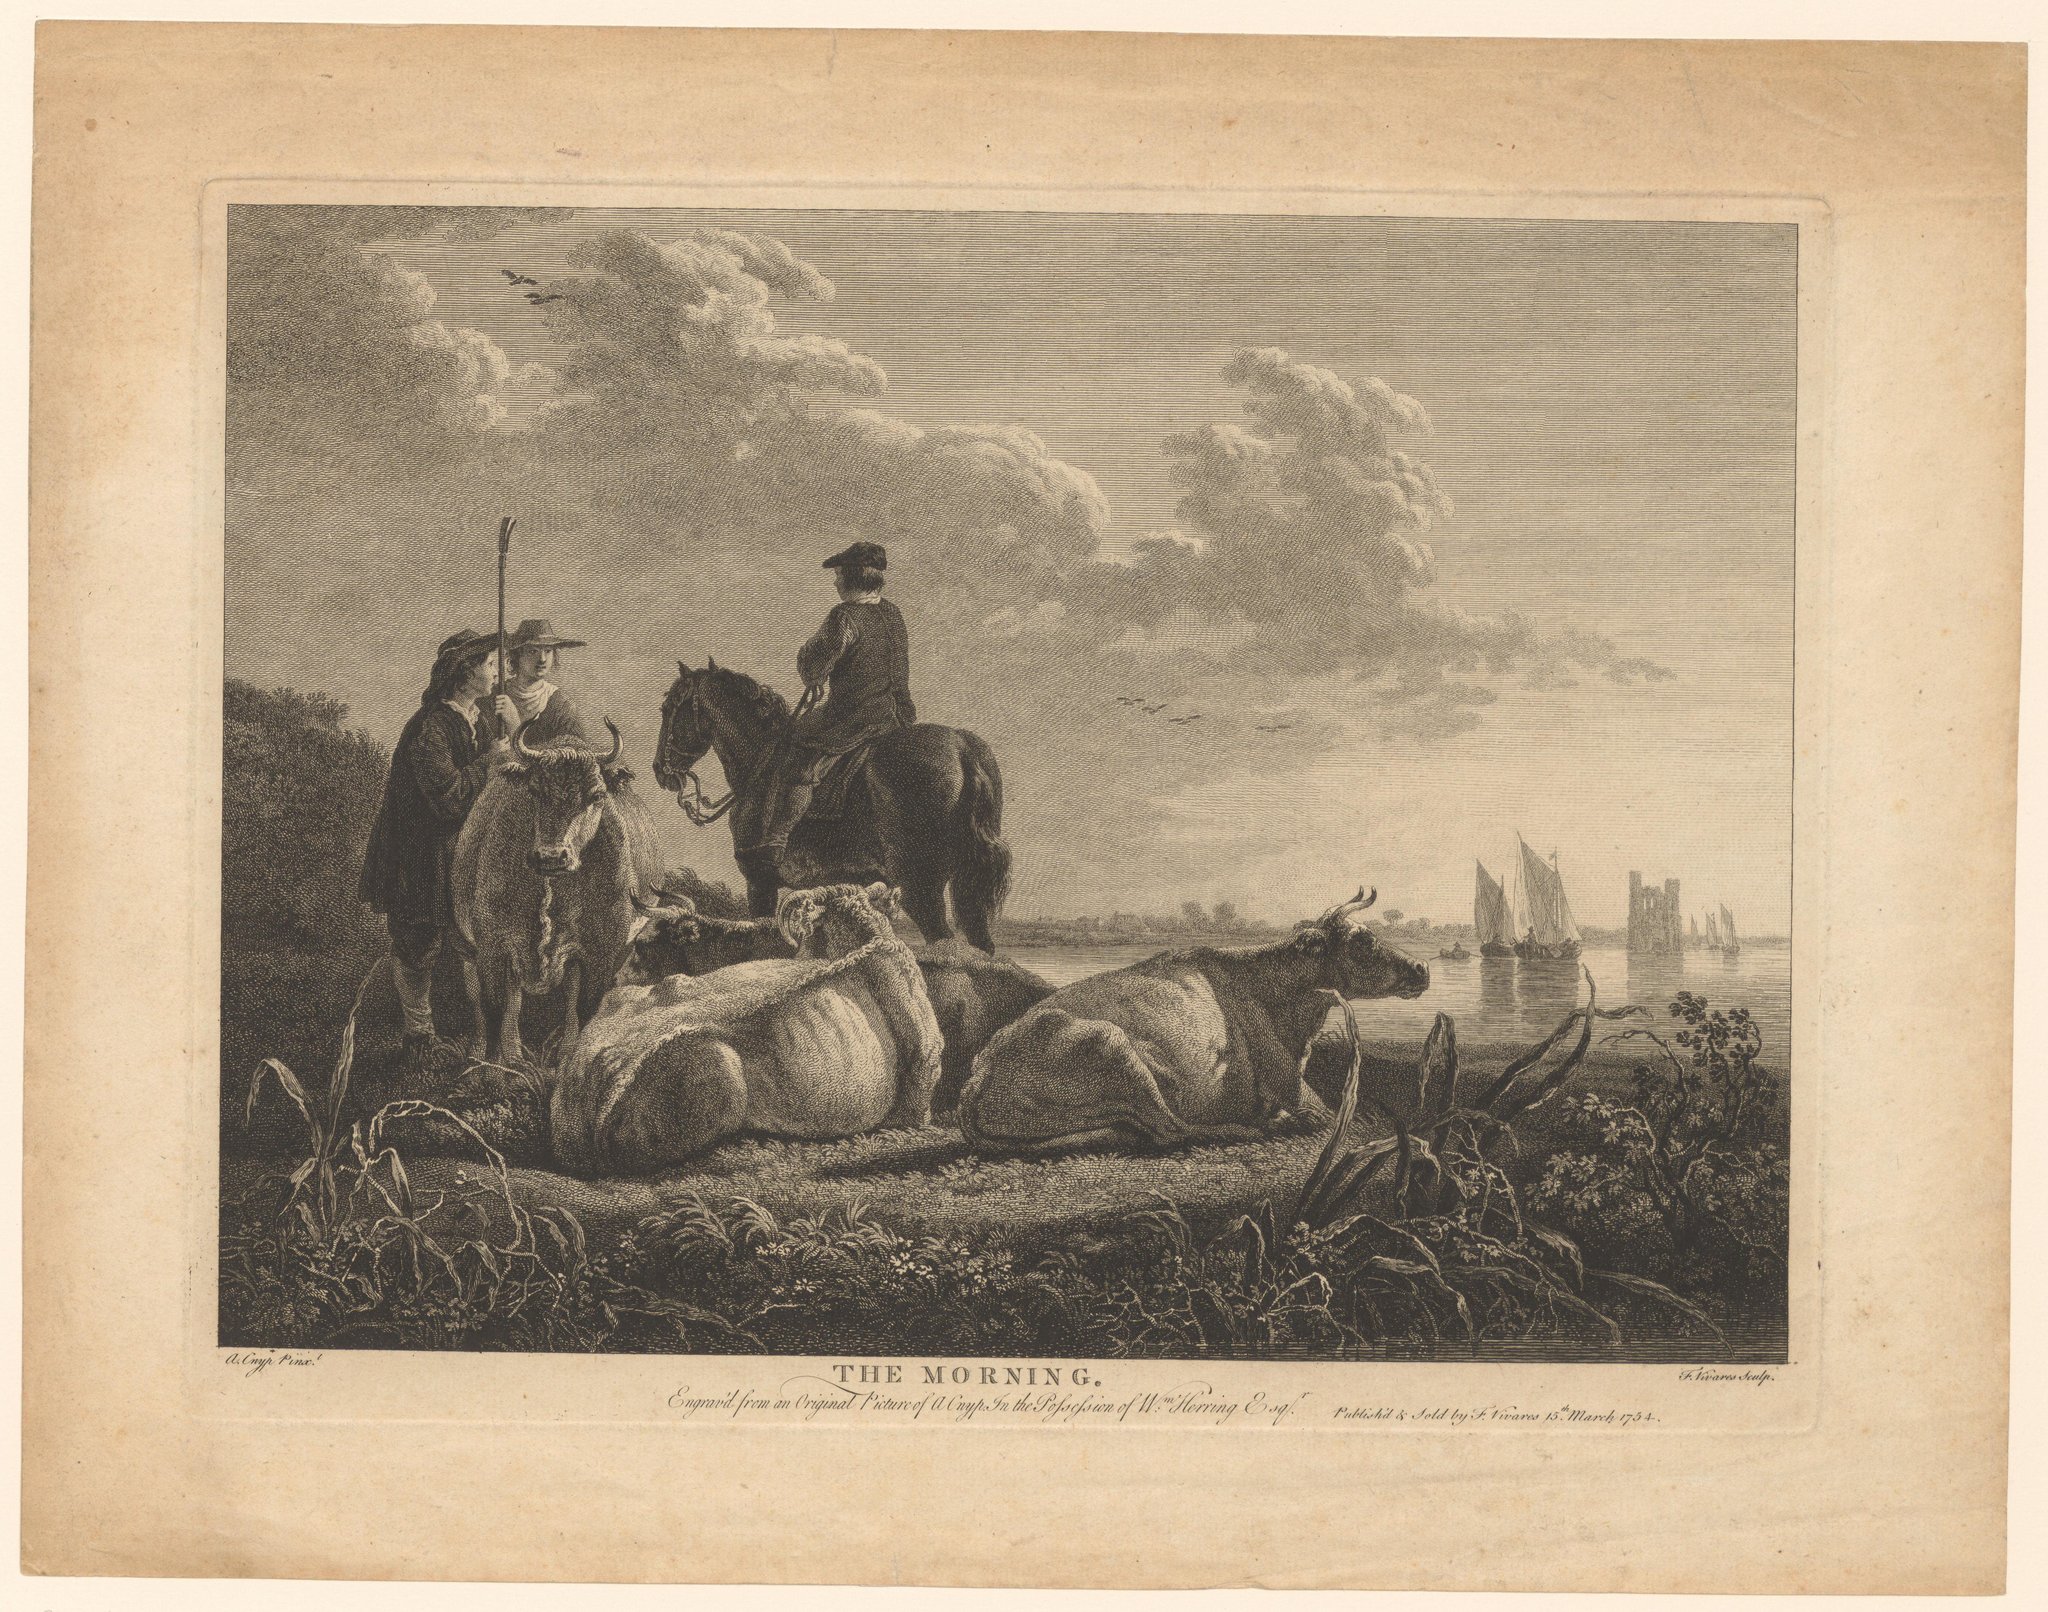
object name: print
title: Herders en ruiter bij koeien aan het water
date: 1754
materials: paper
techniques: engraving, etching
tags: cow, morning, river bank, herd, flock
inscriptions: collector's mark: Lugt 2228